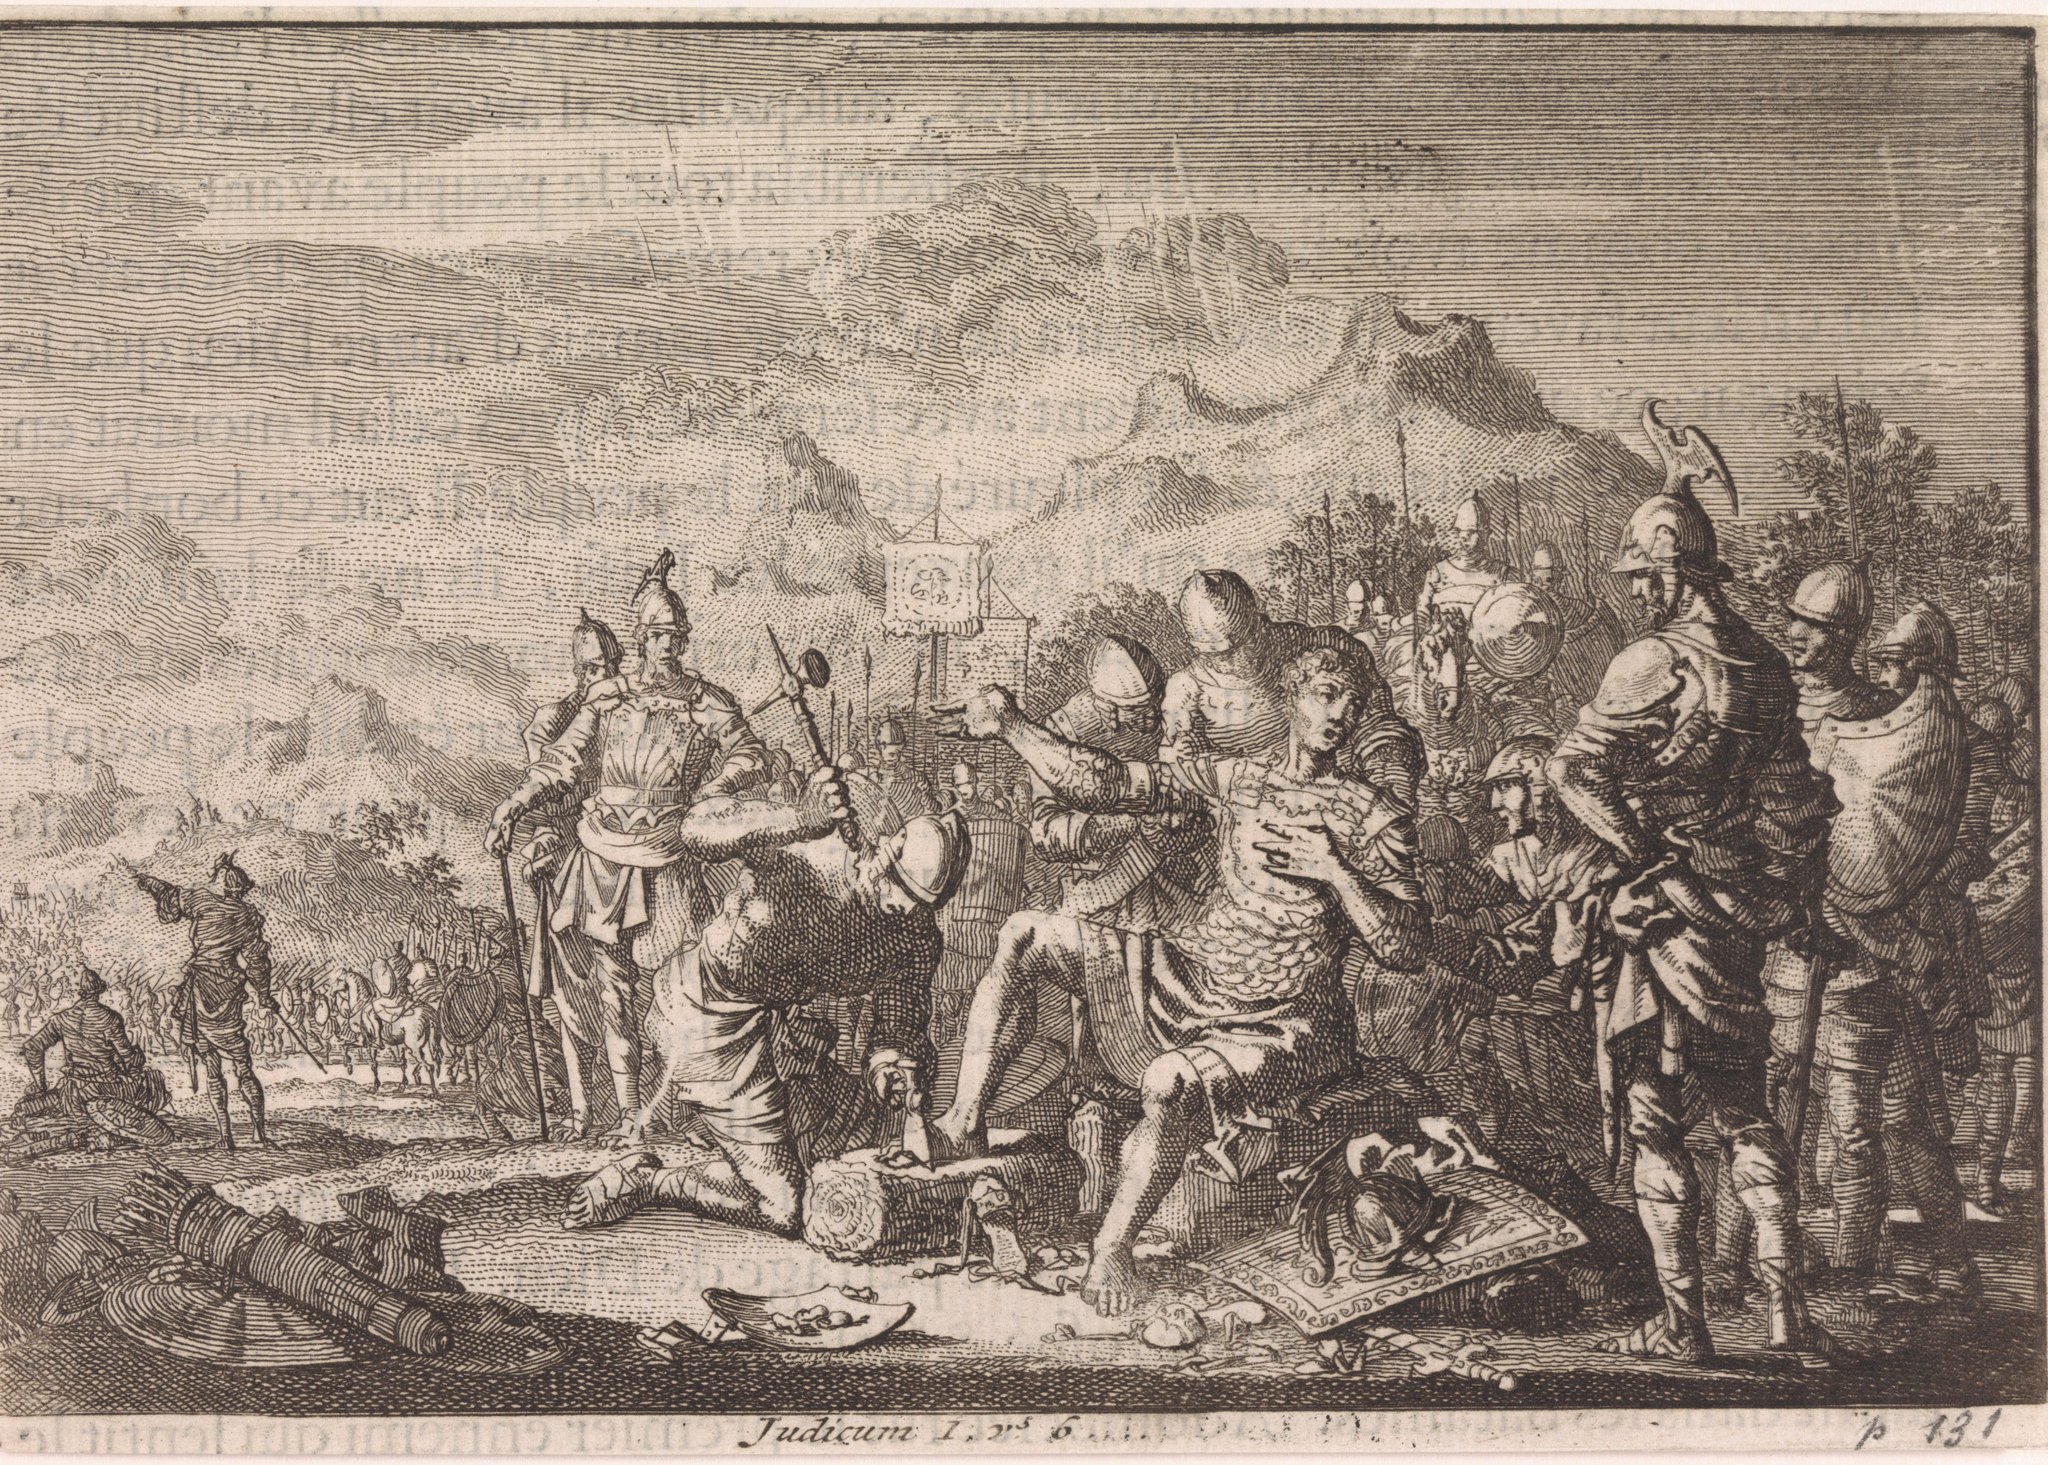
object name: print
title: Verminking van Adonibezek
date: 1703-1762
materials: paper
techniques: etching, letterpress printing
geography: amsterdam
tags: adoni-bezek is caught; his thumbs and his great toes are cut off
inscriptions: collector's mark: Lugt 2228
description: De prent komt een eerste keer voor als boekillustratie voor David Martin. Historie des Ouden en Nieuwen Testaments. Amsterdam, Pieter Mortier, 1703. Deel I. De boekillustraties voor de Mortierbijbel hebben verschillende staten en kopieën, waarbij de chronologische volgorde moeilijk te achterhalen valt. Als boekillustraties werden ze bovendien herhaaldelijk opnieuw gebruikt voor andere boekwerken.